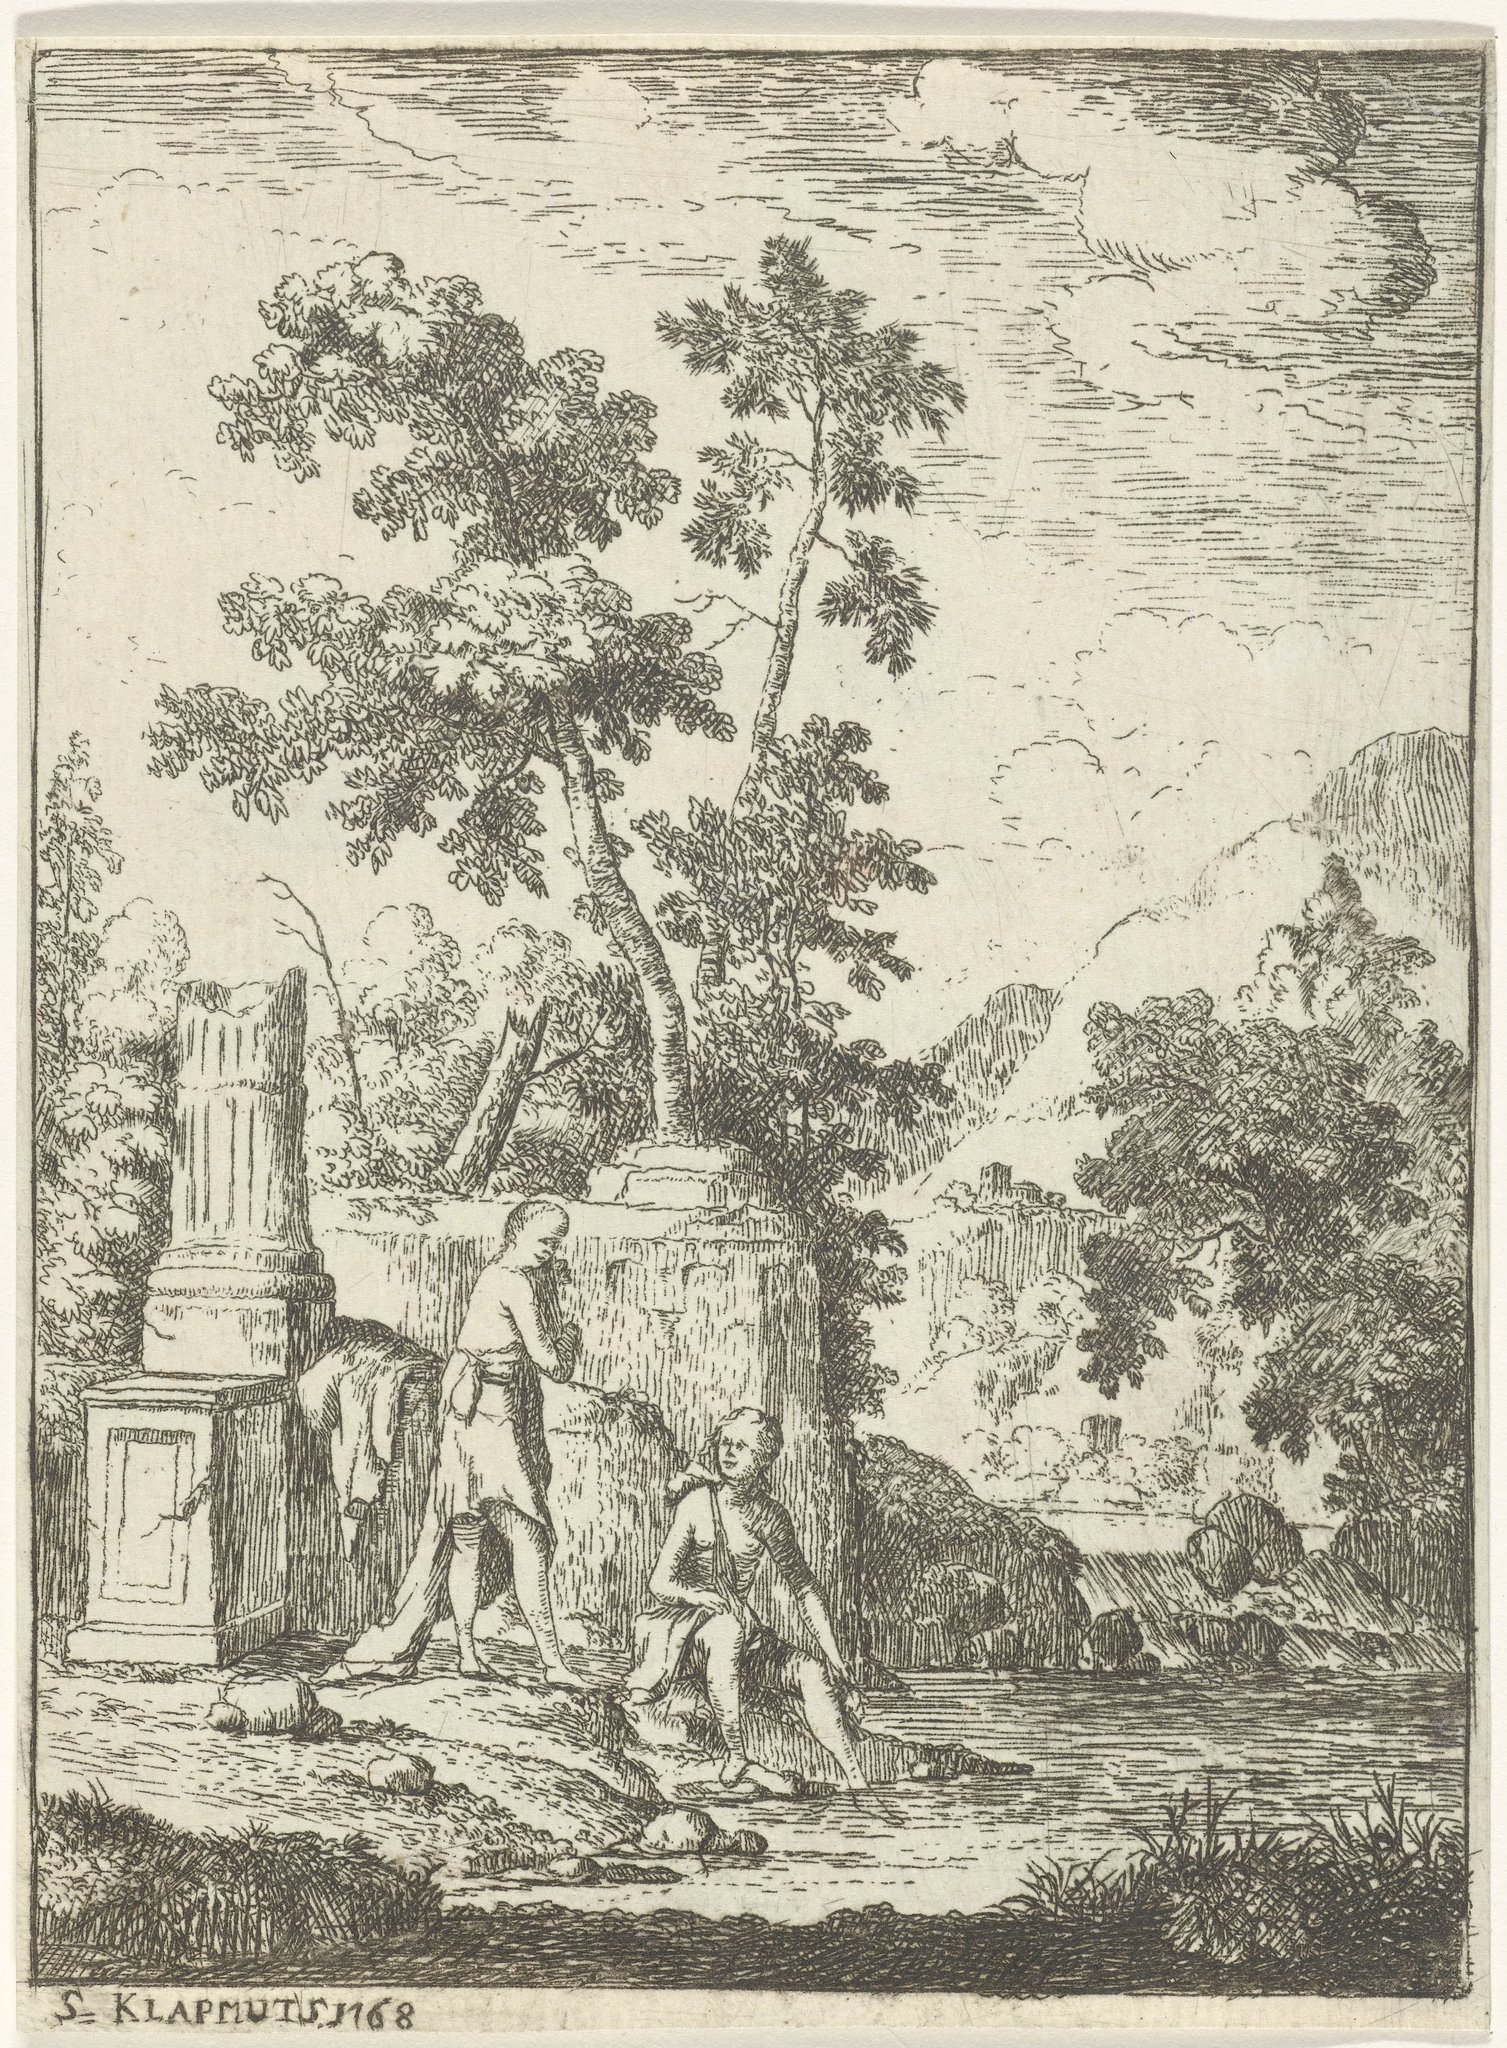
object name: print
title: Badende meisjes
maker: simon klapmuts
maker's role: print maker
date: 1768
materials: paper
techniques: etching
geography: moordrecht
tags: adolescent, young woman, maiden, landscape with ruins, washing and bathing - aa - in the open air, in or beside the water (on the beach)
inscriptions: collector's mark: Lugt 2228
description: In een heuvelachtig landschap bij een ruïne staan twee meisjes te baden aan de oever van een beek.